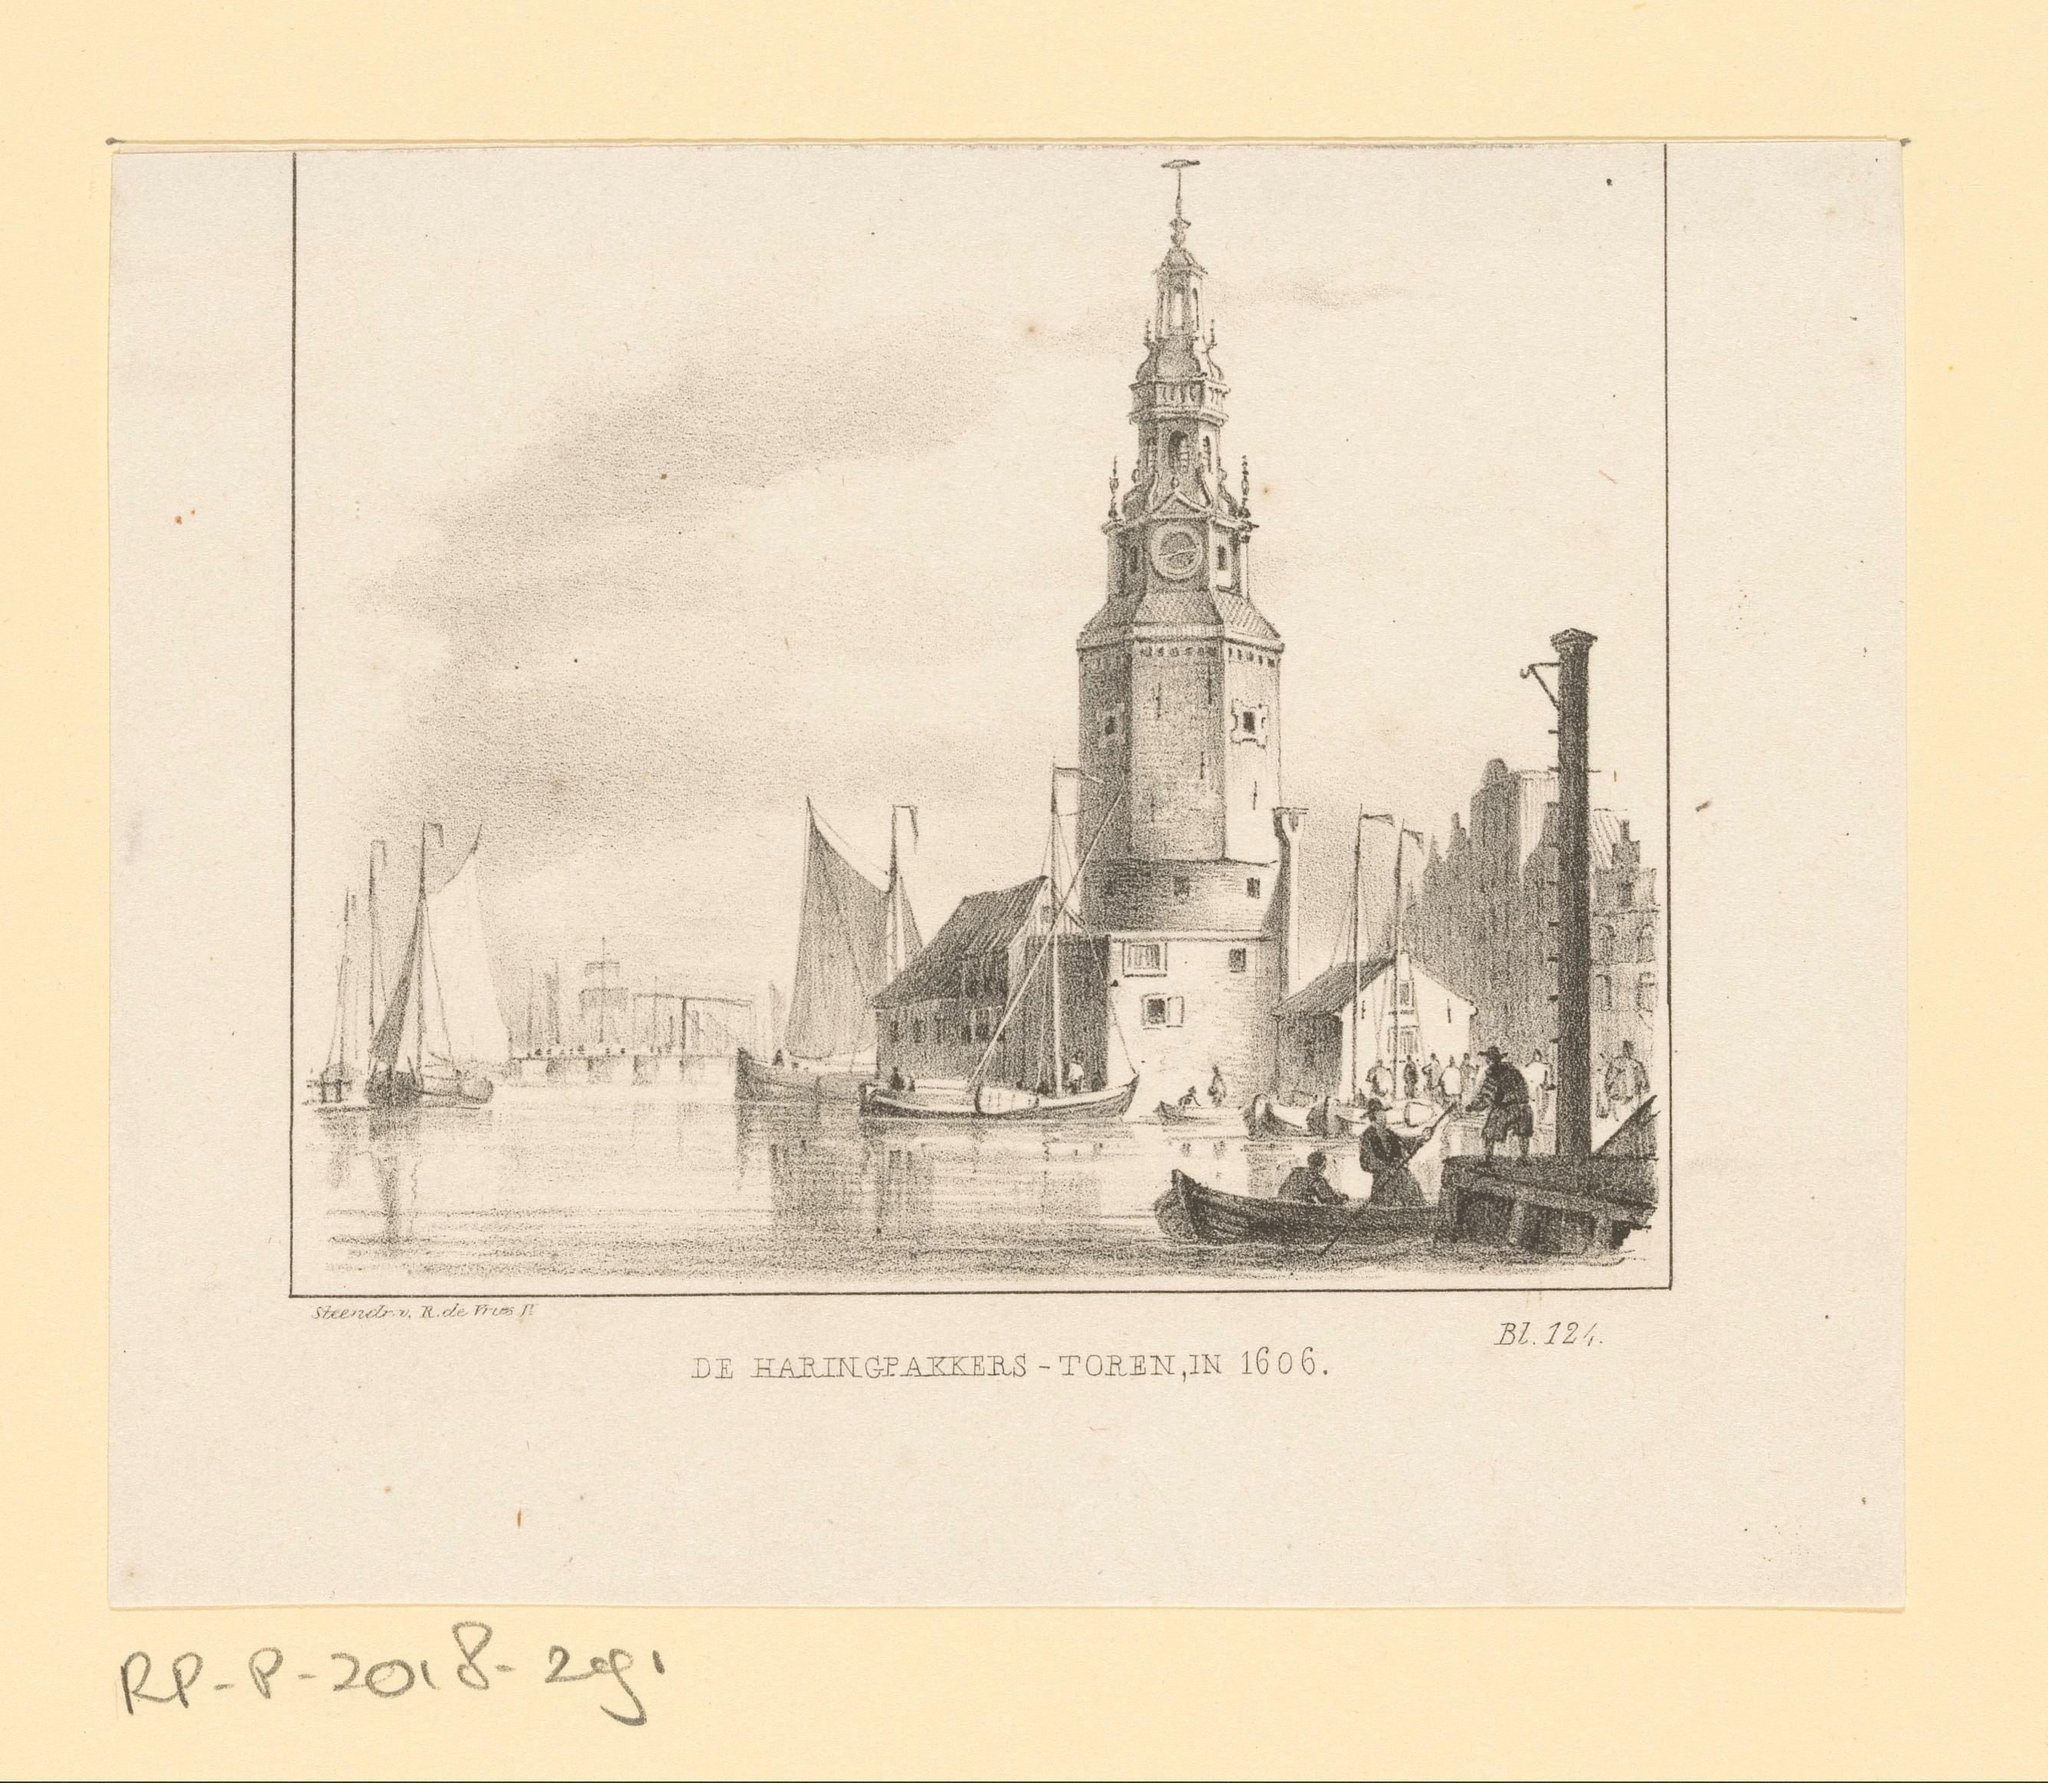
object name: book illustration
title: Gezicht op de Haringpakkerstoren, 1606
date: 1844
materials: paper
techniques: lithograph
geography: amsterdam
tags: tower, clock tower ~ monumental adornment, towers ~ fortified city, canals, waters (in city) (+ city(-scape) with figures, staffage)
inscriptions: collector's mark: Lugt 2228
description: Gezicht op de Haringpakkerstoren, ook bekend als de Heilige Kruistoren, te Amsterdam. In de situatie omstreeks 1606. Gelegen op de hoek van de Haringpakkerij (de latere Prins Hendrikkade) en de Singel. Rechtsonder genummerd: Bl. 124.